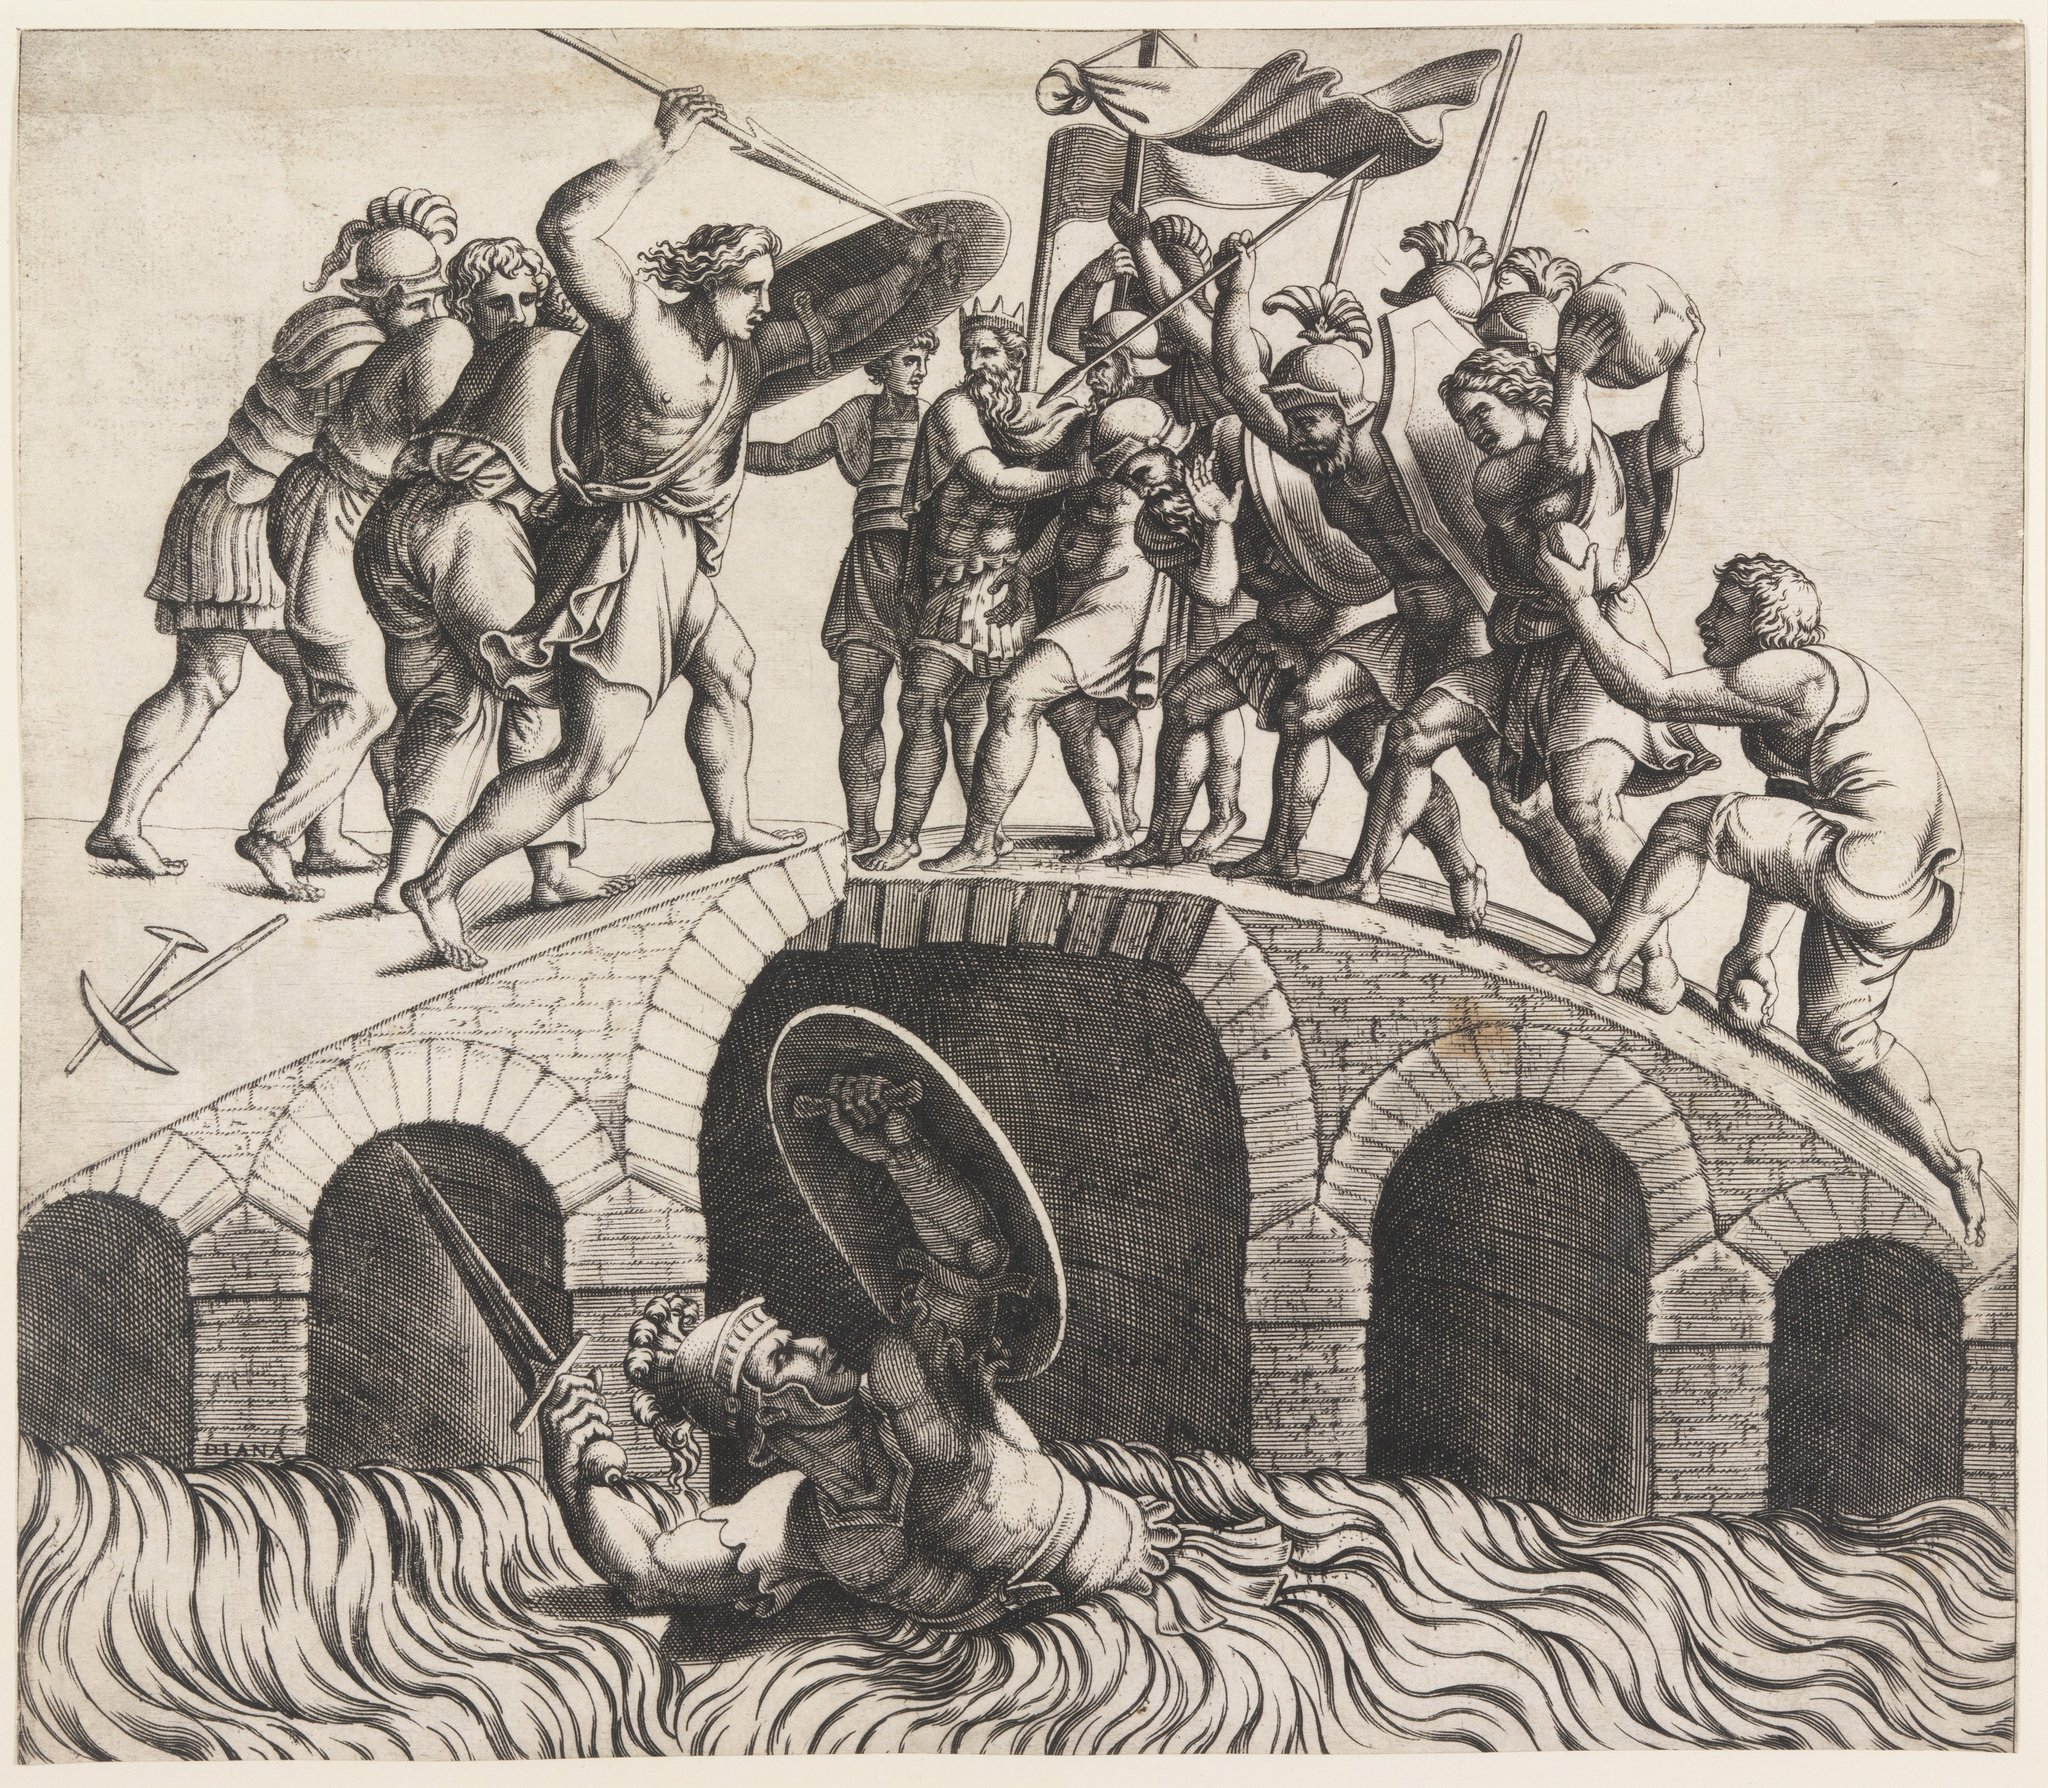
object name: print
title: Horatio Coclès Saving Himself by Swimming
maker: diana scultori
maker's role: artist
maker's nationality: italian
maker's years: 1535-1588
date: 1501-1600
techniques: engraving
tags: battles,shields,swords,men